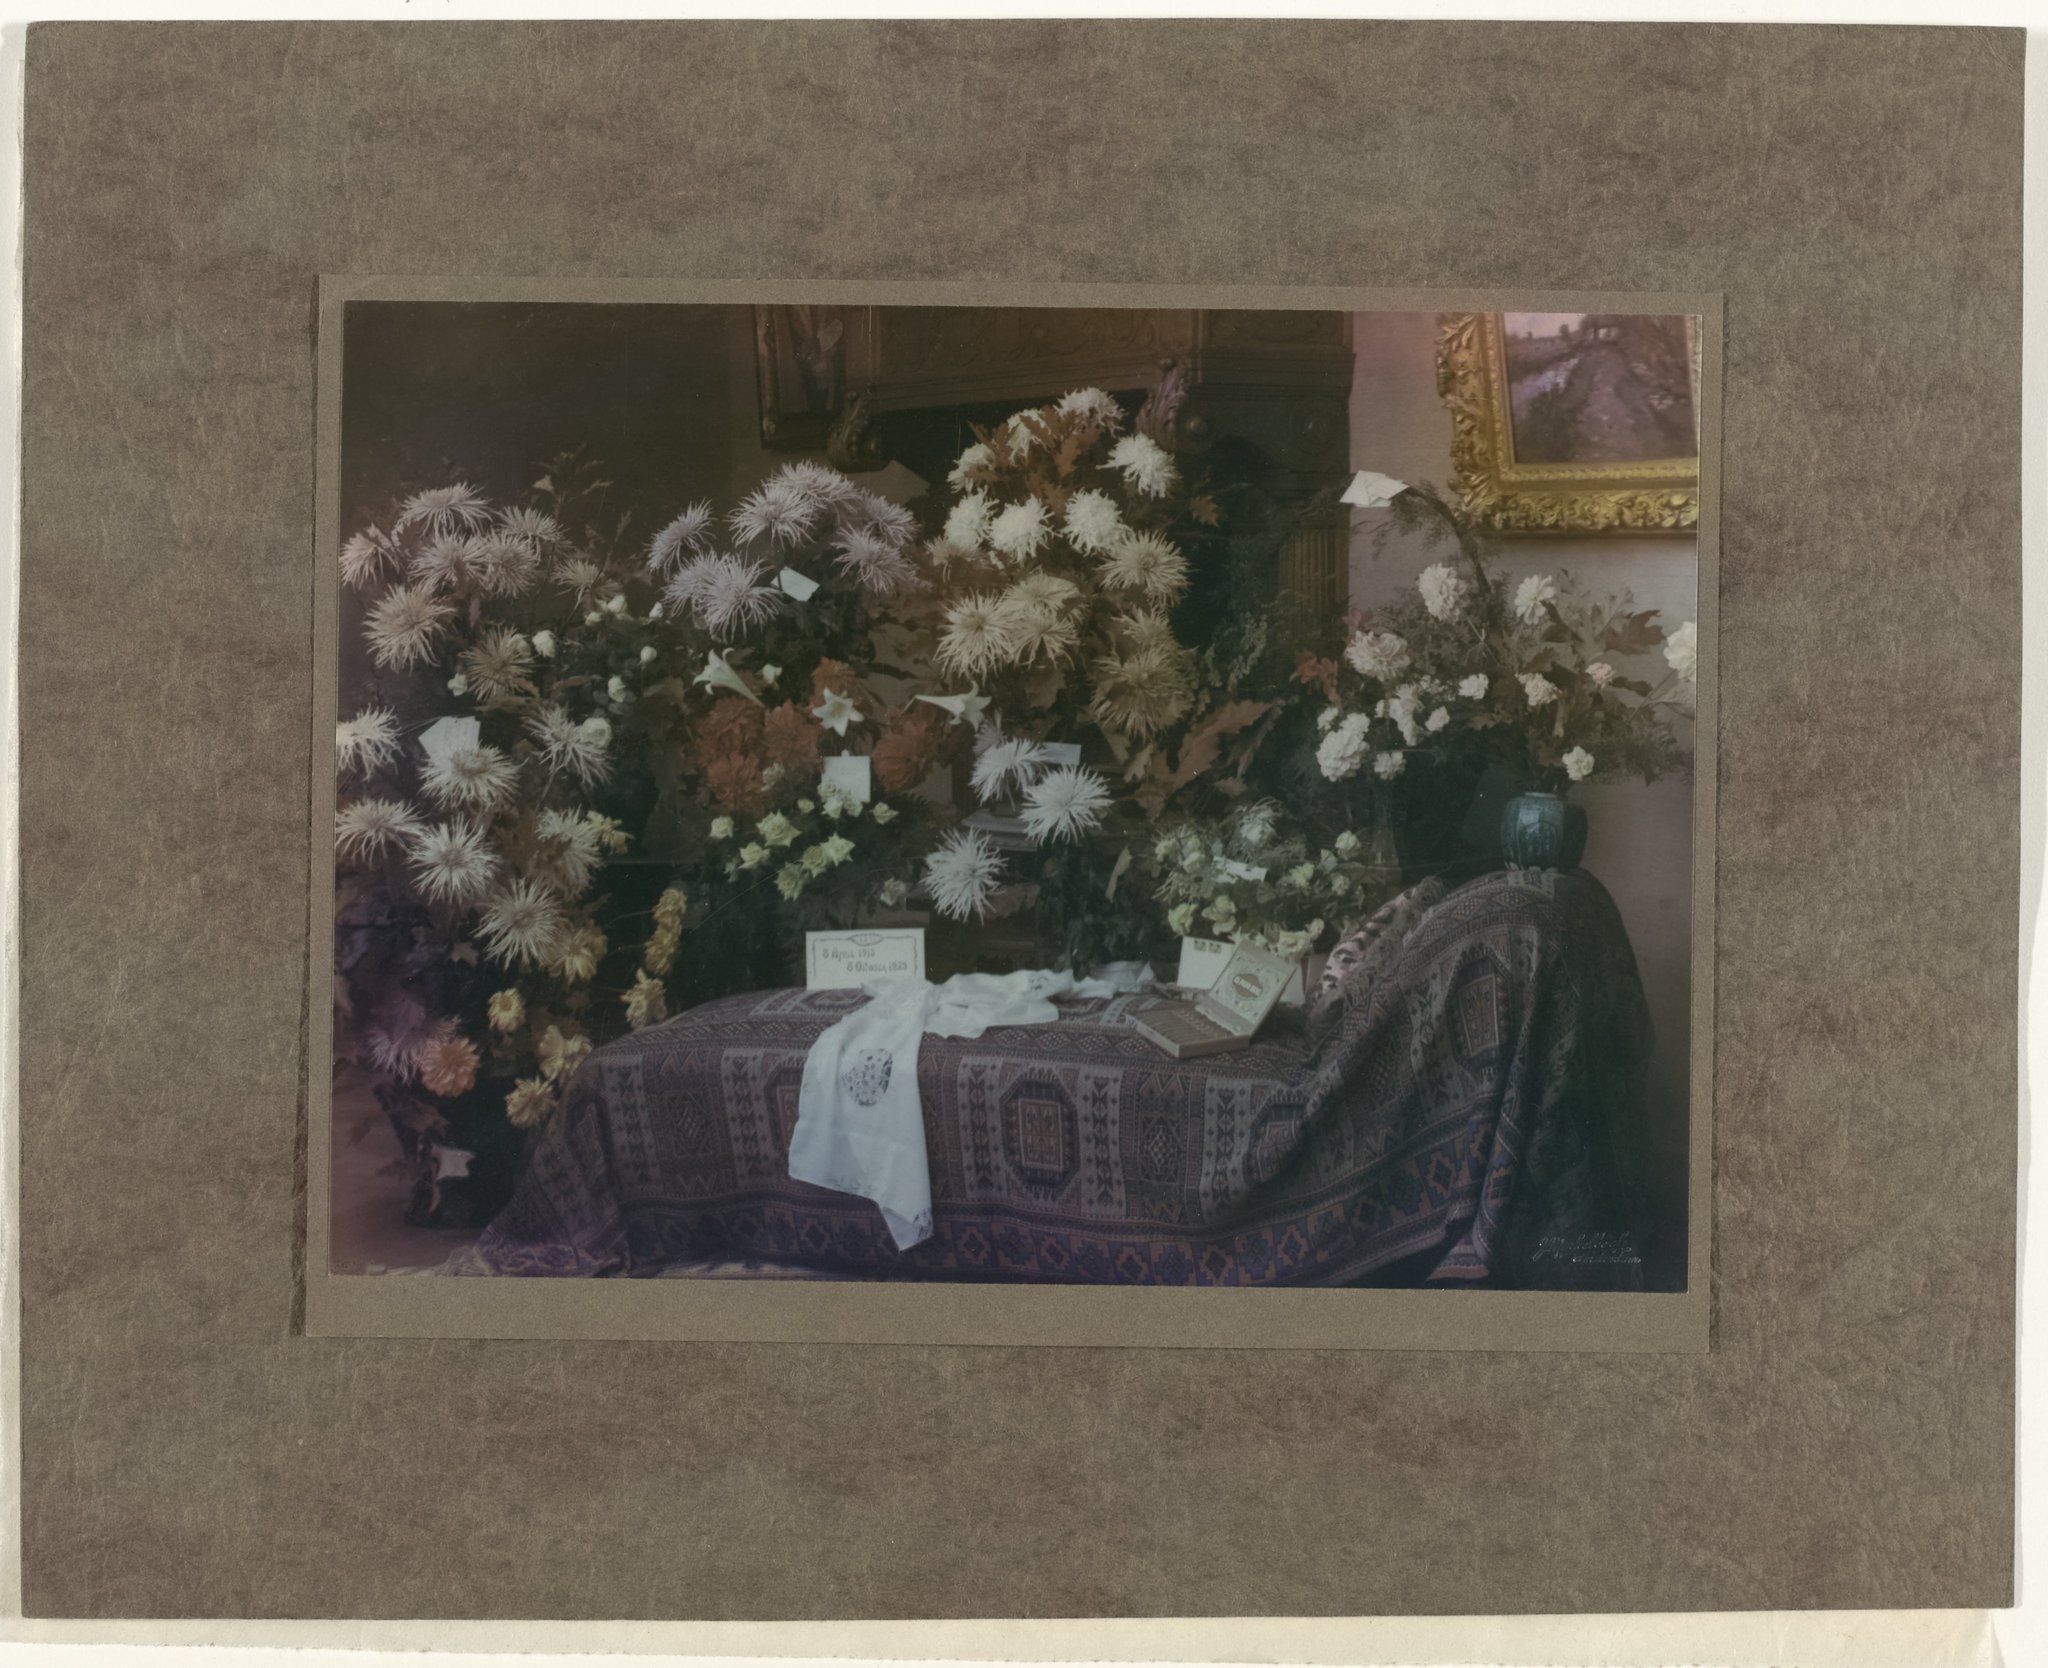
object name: photograph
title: Bloemen ter gelegenheid van twaalf en een half jarig jubileum Merkelbach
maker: jacob merkelbach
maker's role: fotograaf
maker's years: 1877-1942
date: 1925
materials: cardboard, paper, photographic support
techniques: jos-pé print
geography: amsterdam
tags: cut flowers; nosegay, bunch of flowers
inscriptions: check stamp: ‘J. Merkelbach Amsterdam’, inscription: ‘Foto Merkelbacht ... jubileum Merkelbach Jos Pe’